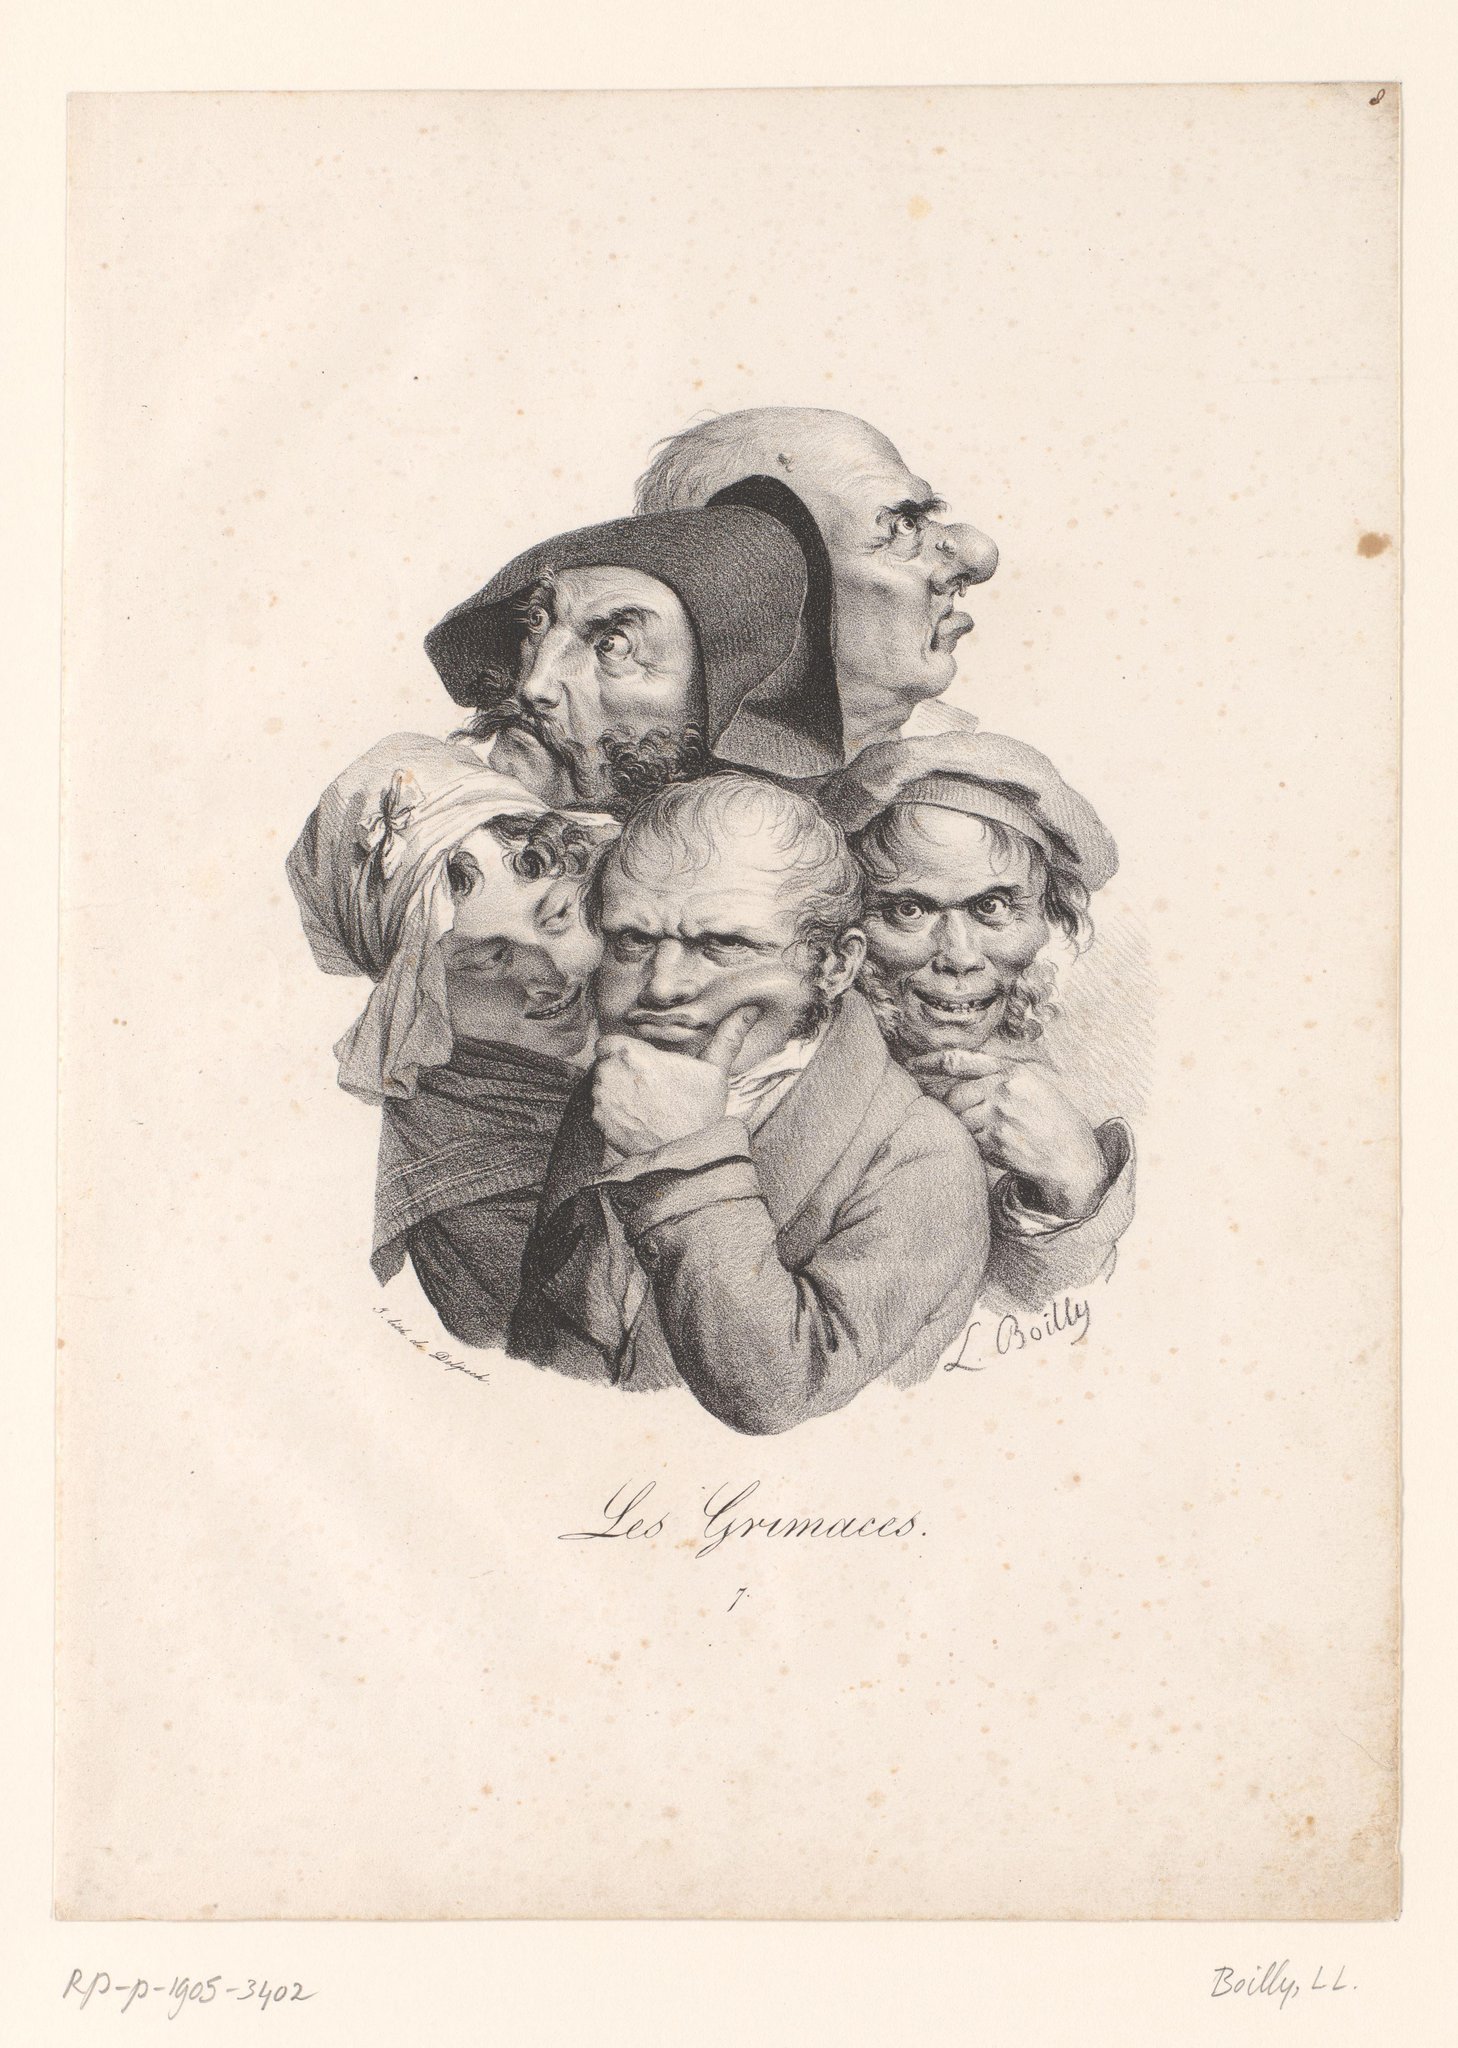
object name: cartoon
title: Gezichten met een grimas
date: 1823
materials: paper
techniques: lithograph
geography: paris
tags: caricatures (human types), morphology of facial expression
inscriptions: collector's mark: Lugt 2228a, number: ‘8’